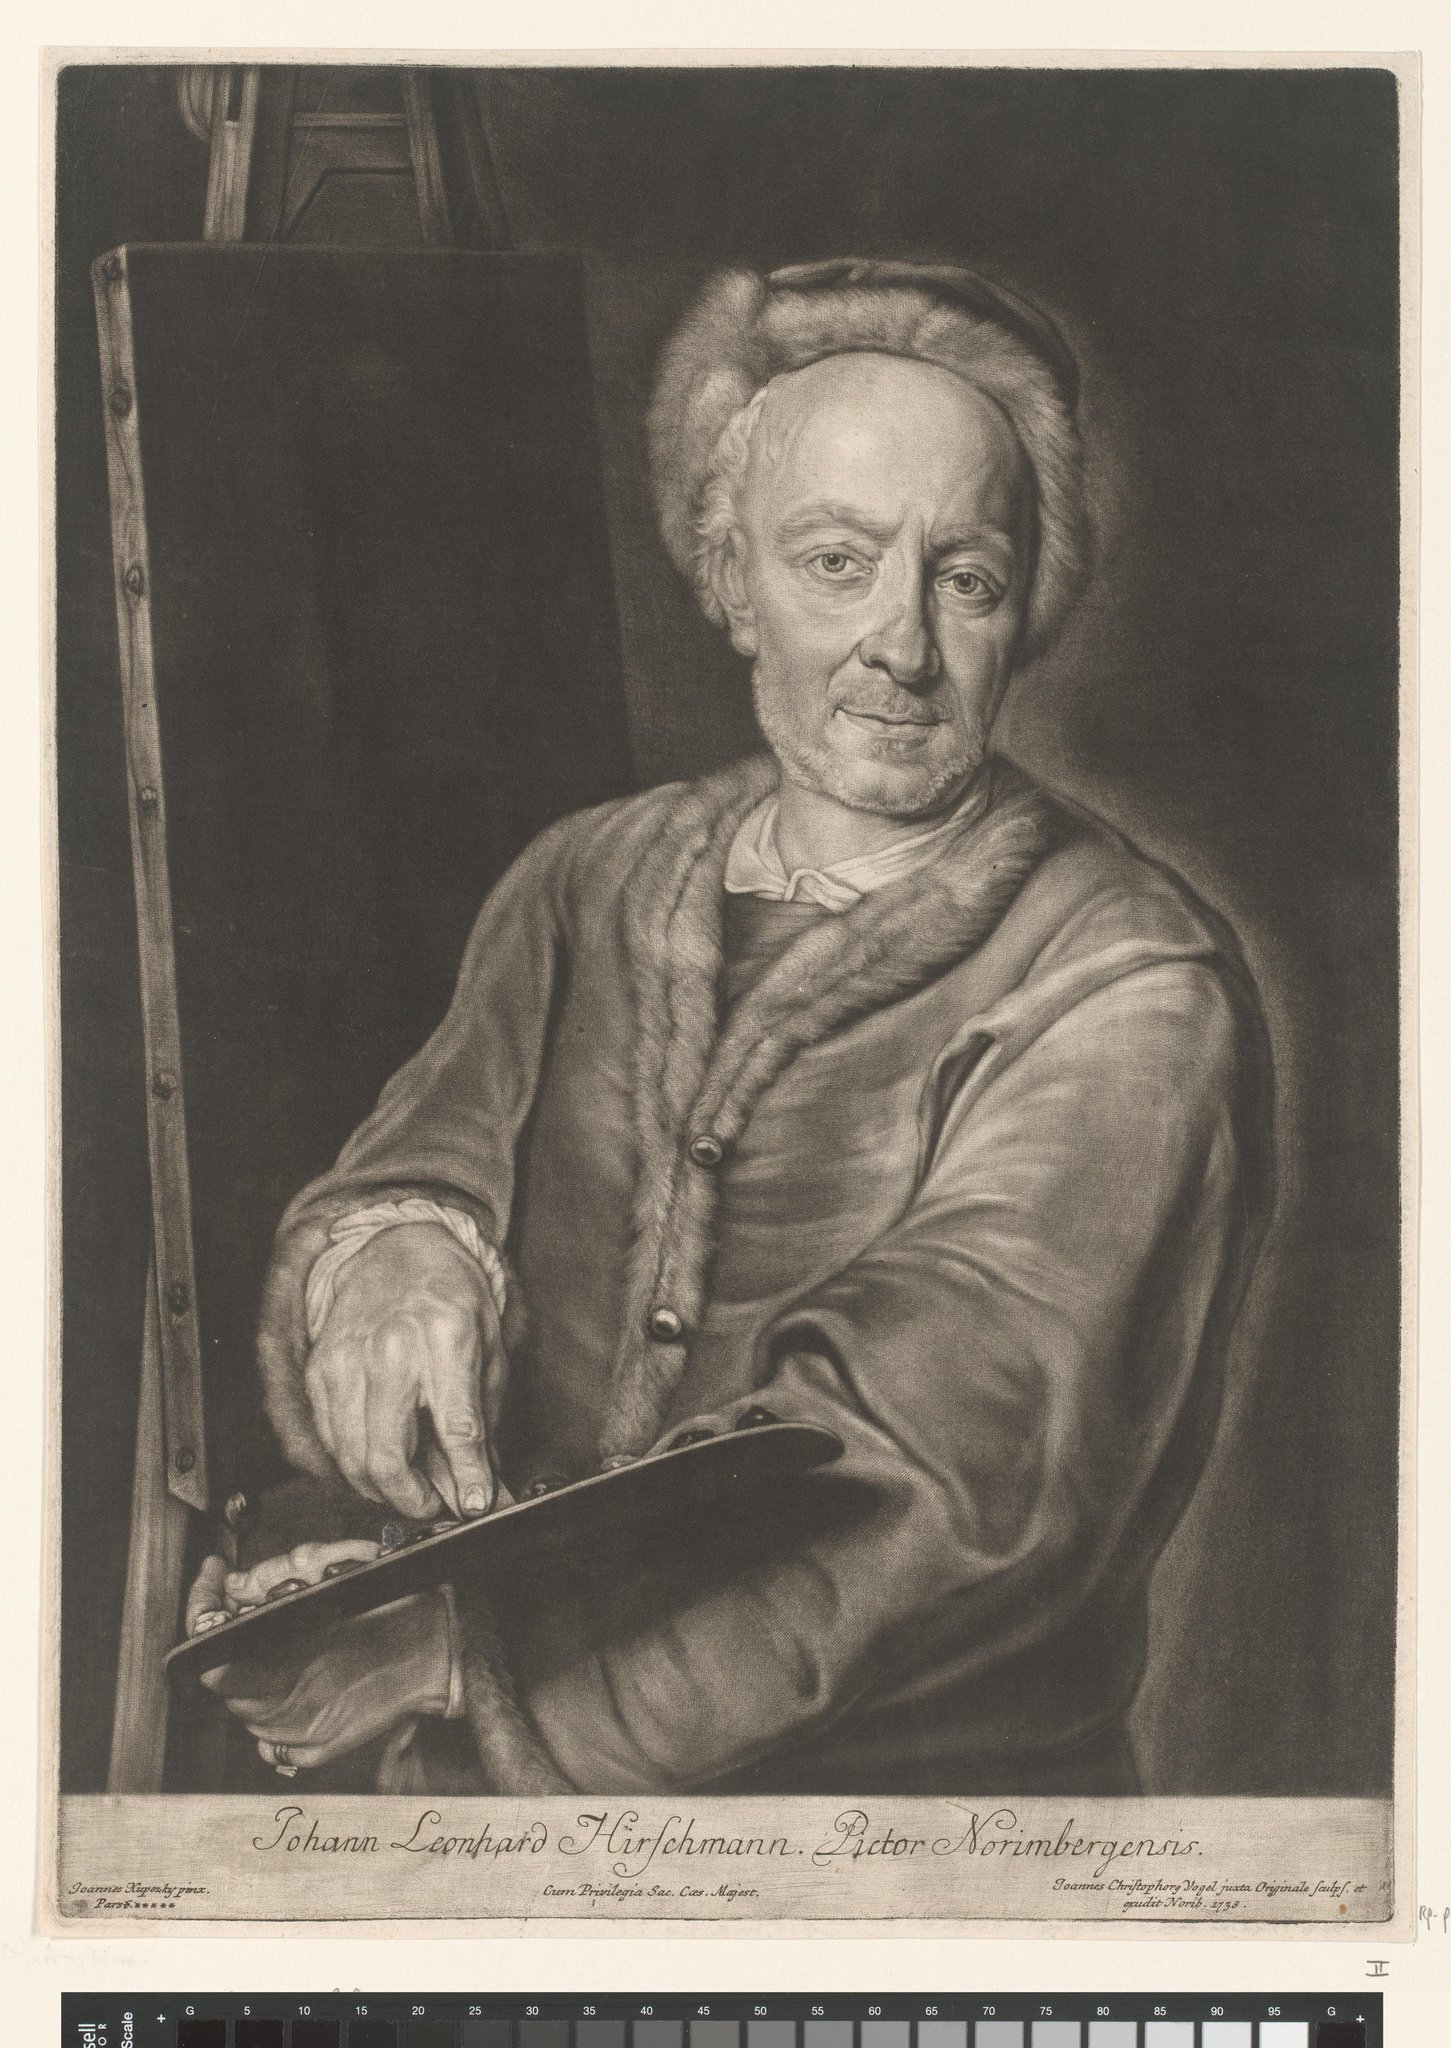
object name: print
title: Portret van Johann Leonhard Hirschmann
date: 1738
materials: paper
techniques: mezzotint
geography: paris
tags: print maker, johann leonhard hirschmann, portrait, self-portrait of artist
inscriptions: collector's mark: Lugt 2228